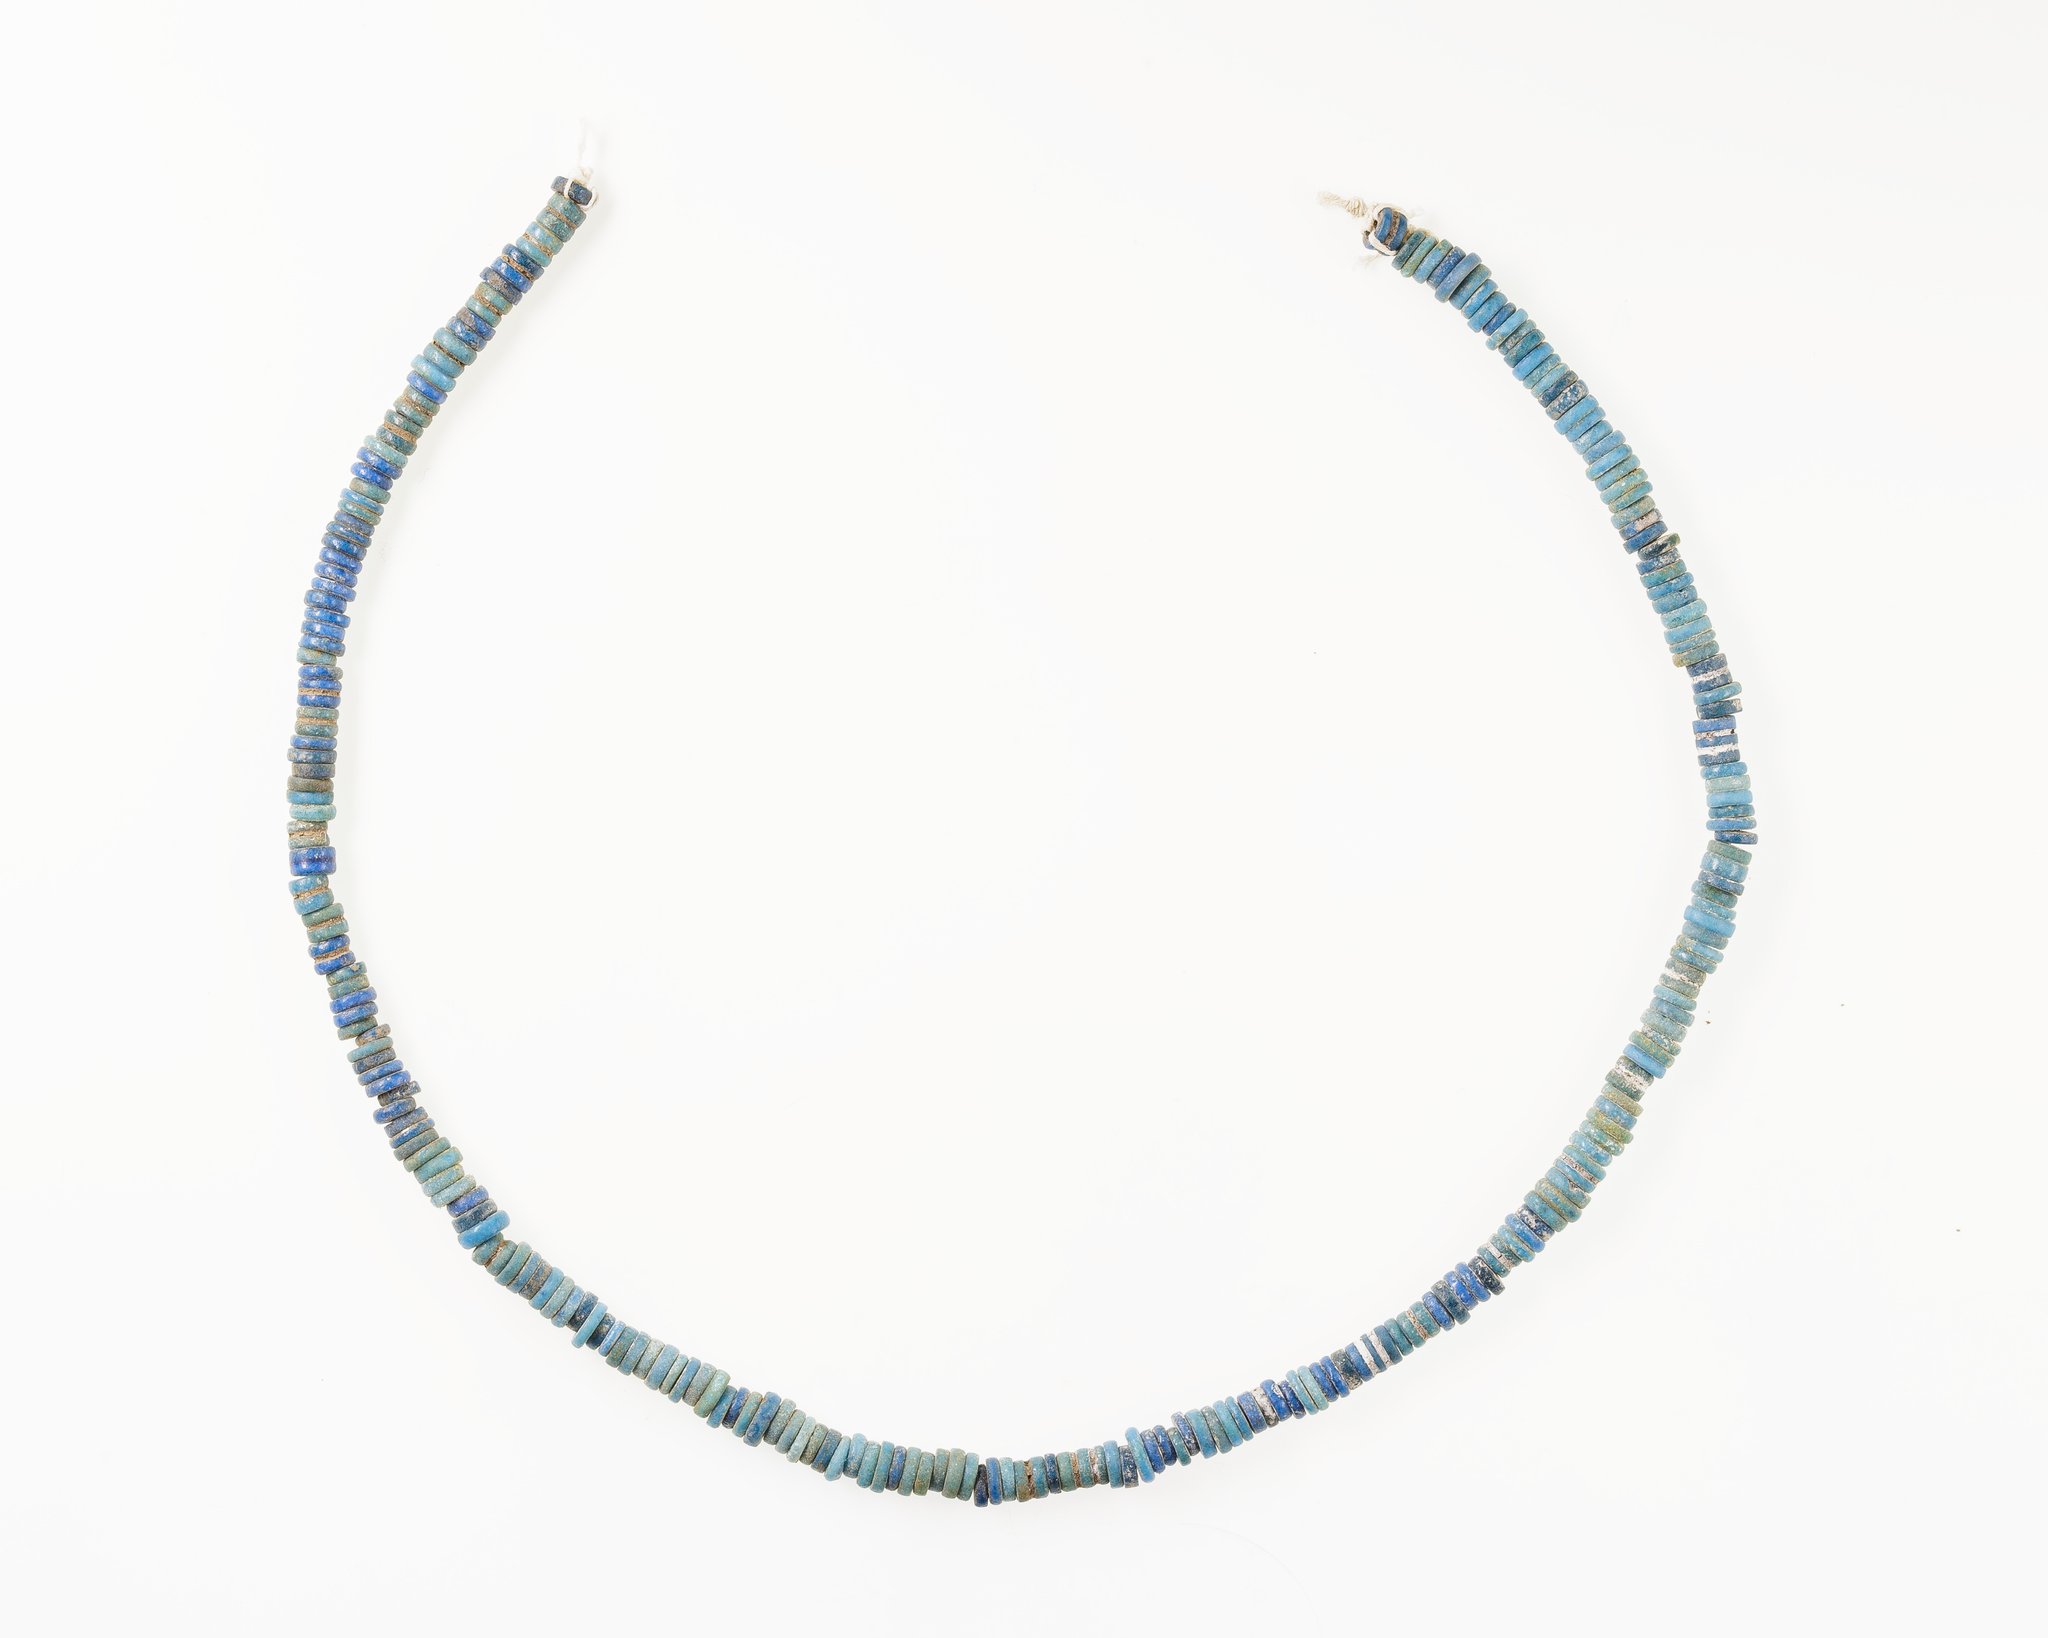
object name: bead, string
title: String of Beads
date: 1070-343 BCE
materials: faience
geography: egypt